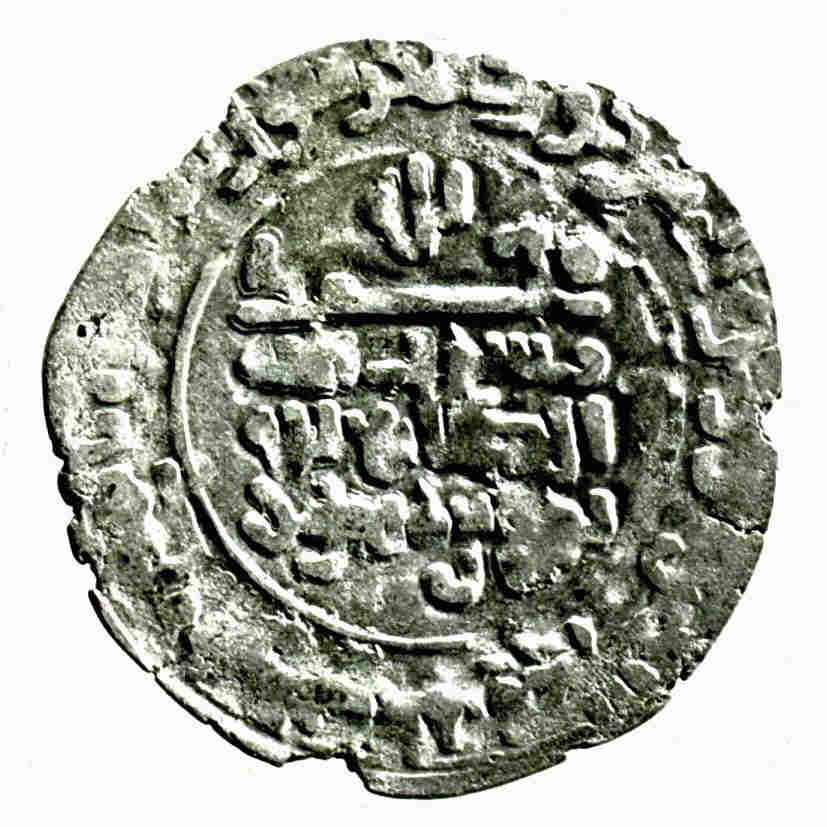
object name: coin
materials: silver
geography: al-shash